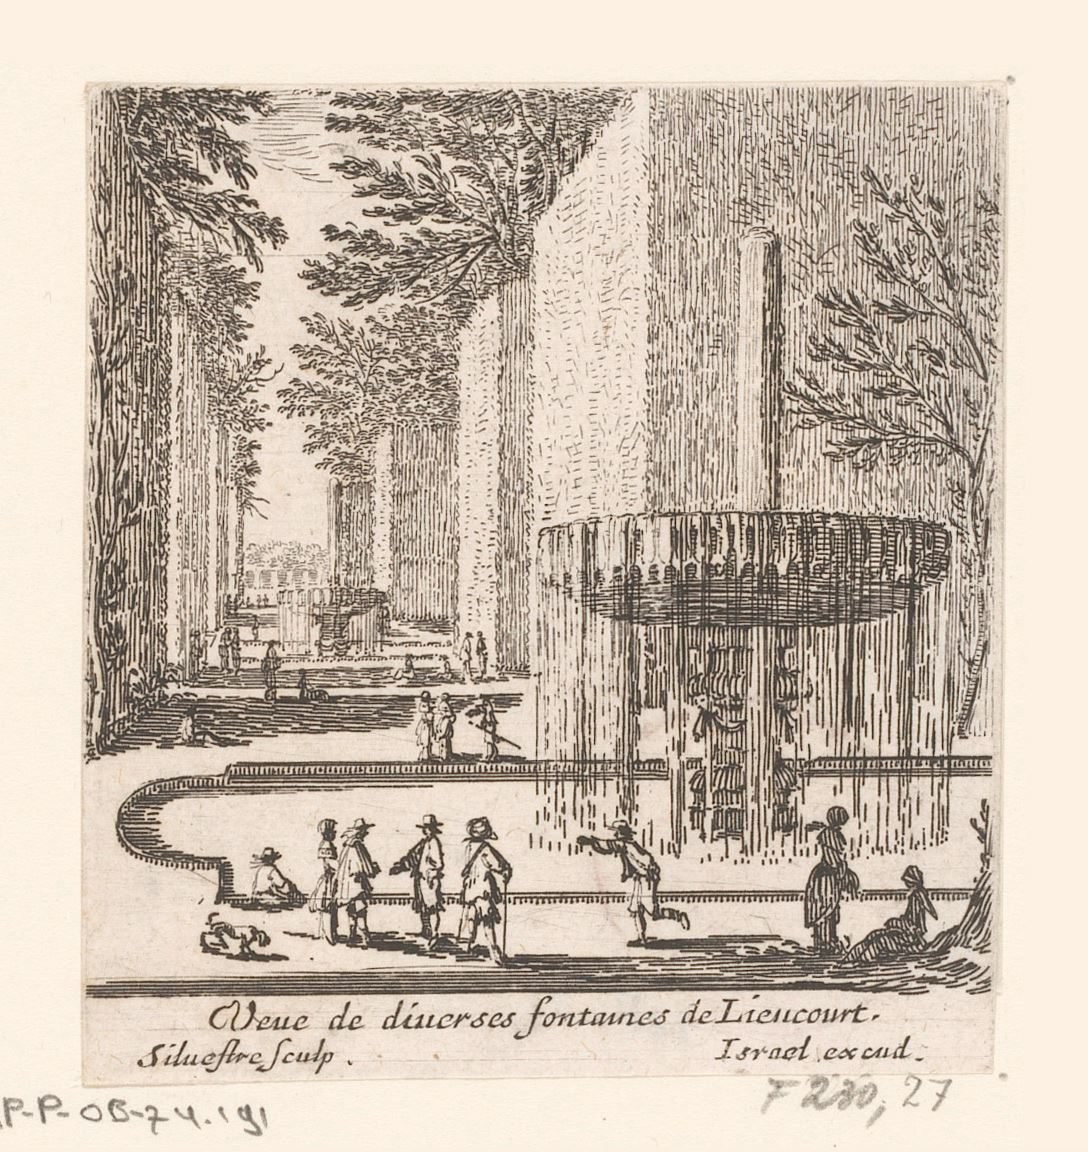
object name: print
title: Veue de diverses fontaines de Liencourt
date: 1655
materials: paper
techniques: engraving, etching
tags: garden fountain, french or architectonic garden; formal garden, landscape with tower or castle, paris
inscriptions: collector's mark: Lugt 240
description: Prent maakt deel uit van een ongenummerde serie van tien prenten.